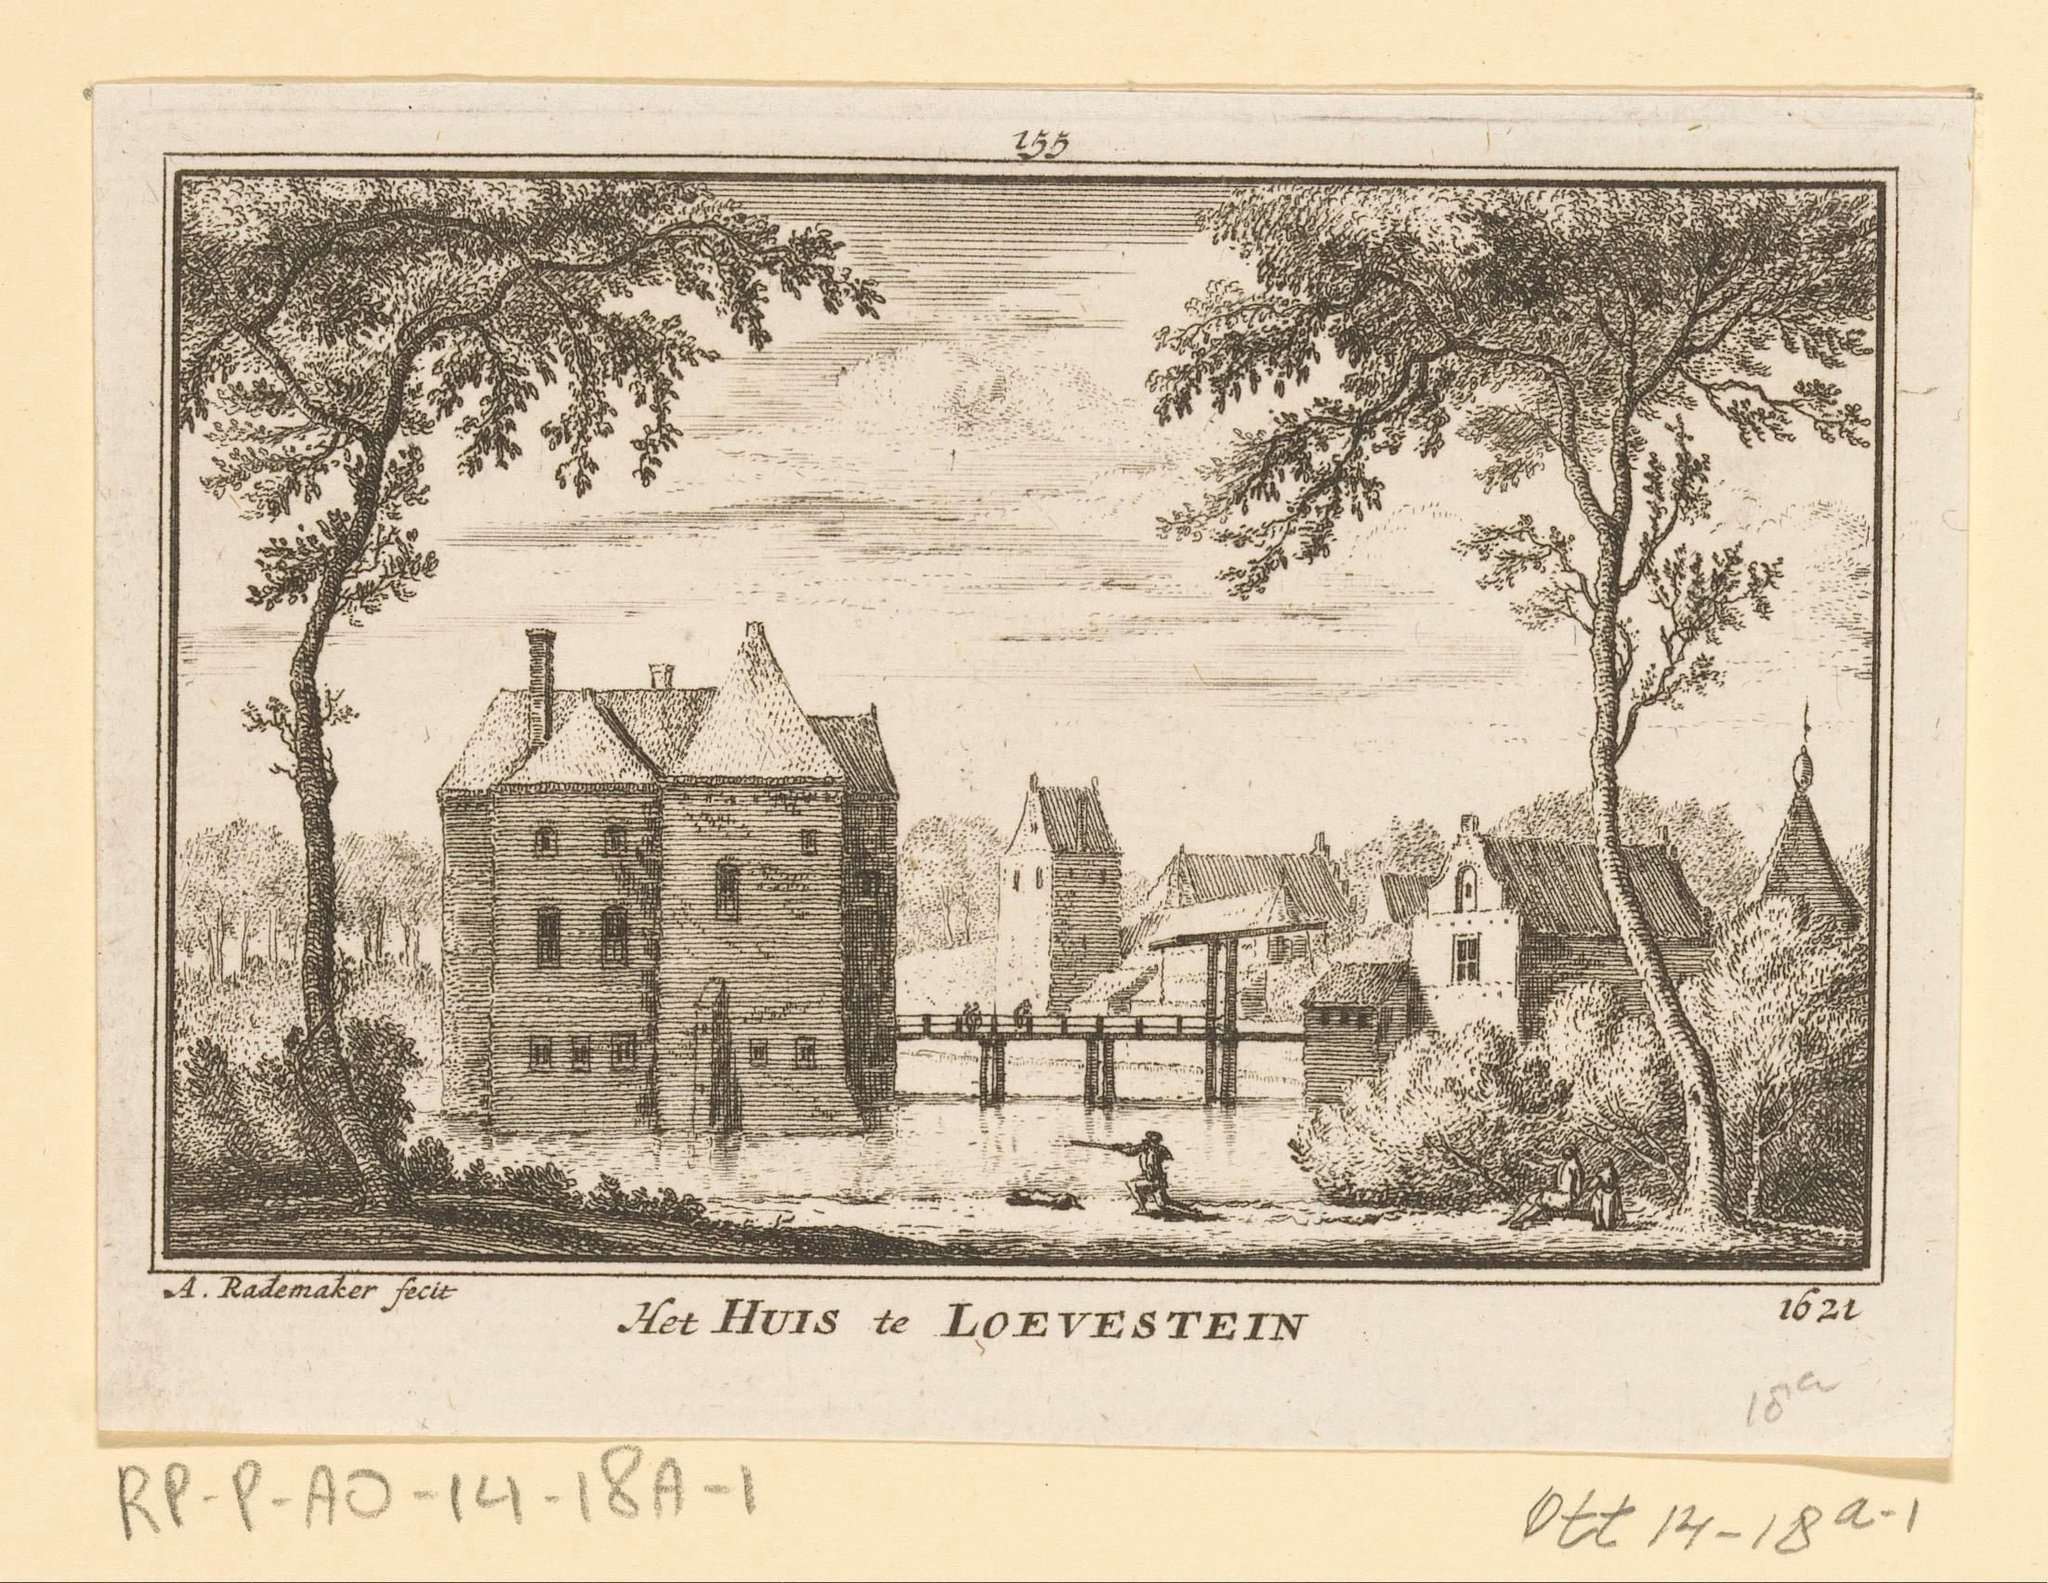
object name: book illustration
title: Gezicht op Slot Loevestein, 1621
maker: abraham rademaker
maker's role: draughtsman, print maker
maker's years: 1676-1735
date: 1725-1803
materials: paper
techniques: engraving, etching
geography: amsterdam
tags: castle, hunter, bridge, loevestein castle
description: Prent ook gebruikt in: Rademaker, Abraham. Kabinet van Nederlandsche outheden en gezichten: vervat in 300 konstplaaten (…). 2 delen. Amsterdam: Willem Barents, 1725, dl. 2, ill. 155. Na 1725 is deze prent nog in verschillende heruitgaven verschenen, uitgegeven in 1727-1733, 1770-1771 en 1792-1803. Uit welke uitgave het huidige exemplaar precies komt is niet na te gaan.